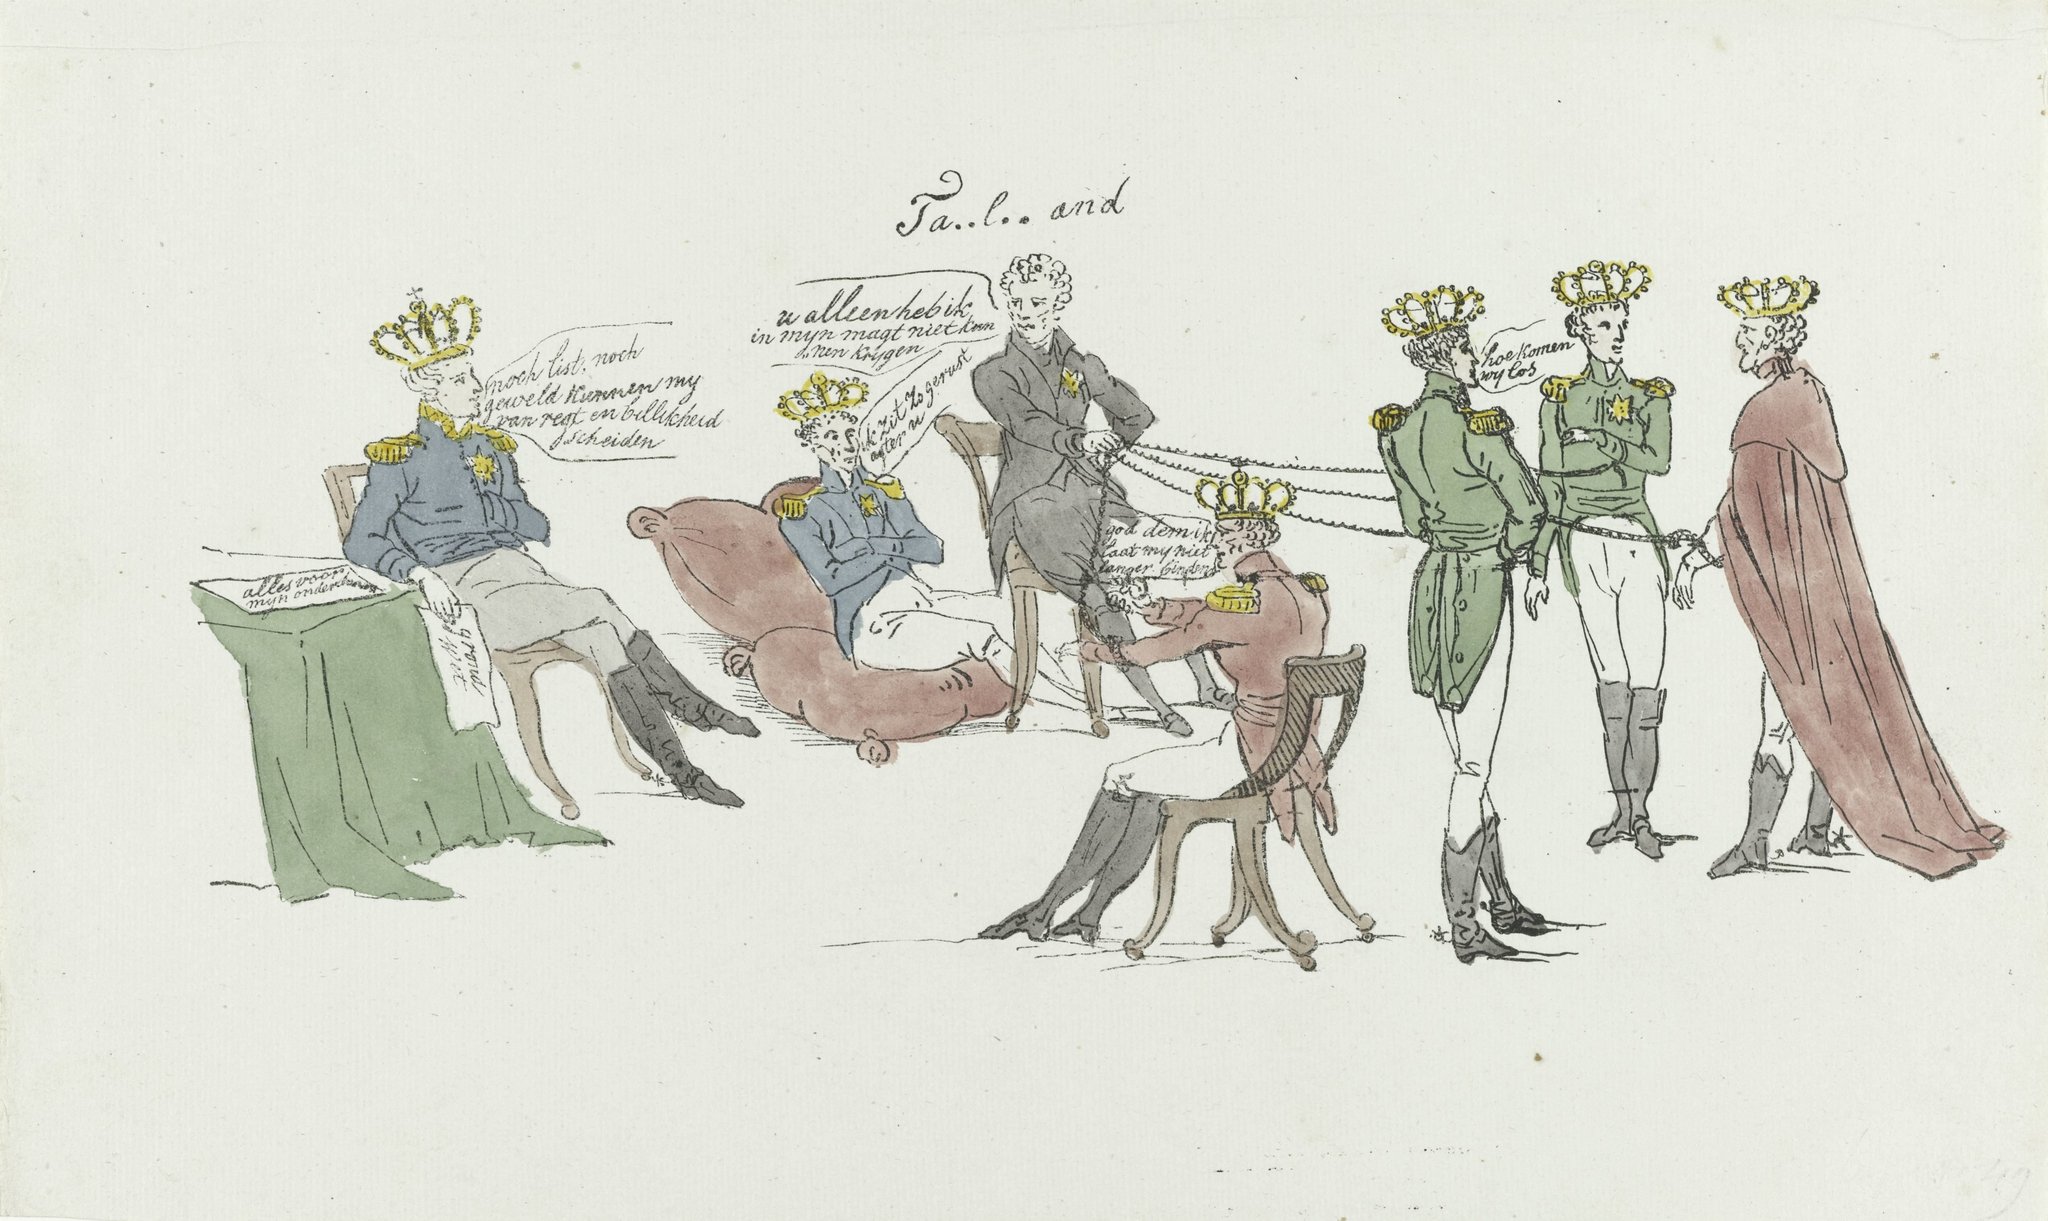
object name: cartoon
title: Spotprent op de Franse rol tijdens de Conferentie te Londen, 1831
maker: Anonymous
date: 1831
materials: paper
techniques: hand coloring, lithograph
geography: netherlands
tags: berlin, william i of the netherlands, paris, politician, charles maurice hertog van talleyrand-périgord, leopold i (koning der belgen), peace negotiations, prisoner; in fetters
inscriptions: collector's mark: Lugt 2228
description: Spotprent op de manipulerende tol van Frankrijk tijdens de Conferentie te Londen waar het Verdrag der XXIV artikelen wordt vastgelegd, 15 november 1831. Talleyrand houdt de vier gekroonde vorsten (Groot-Brittannië, Pruisen, Rusland en Oostenrijk) aan kettingen. Achter Talleyrand zit koning Leopold I op kussens. Links aan een tafel de Nederlandse koning Willem I.